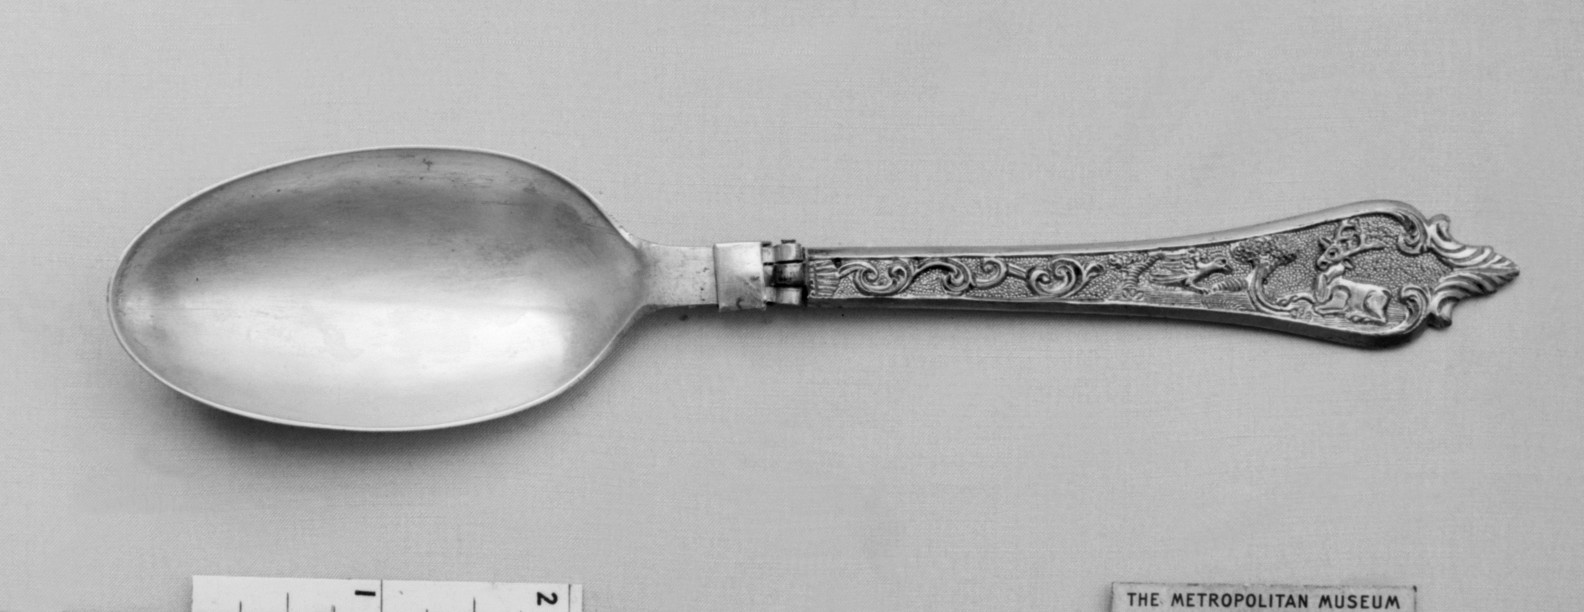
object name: folding spoon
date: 1767-1800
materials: gilt, silver, steel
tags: deer